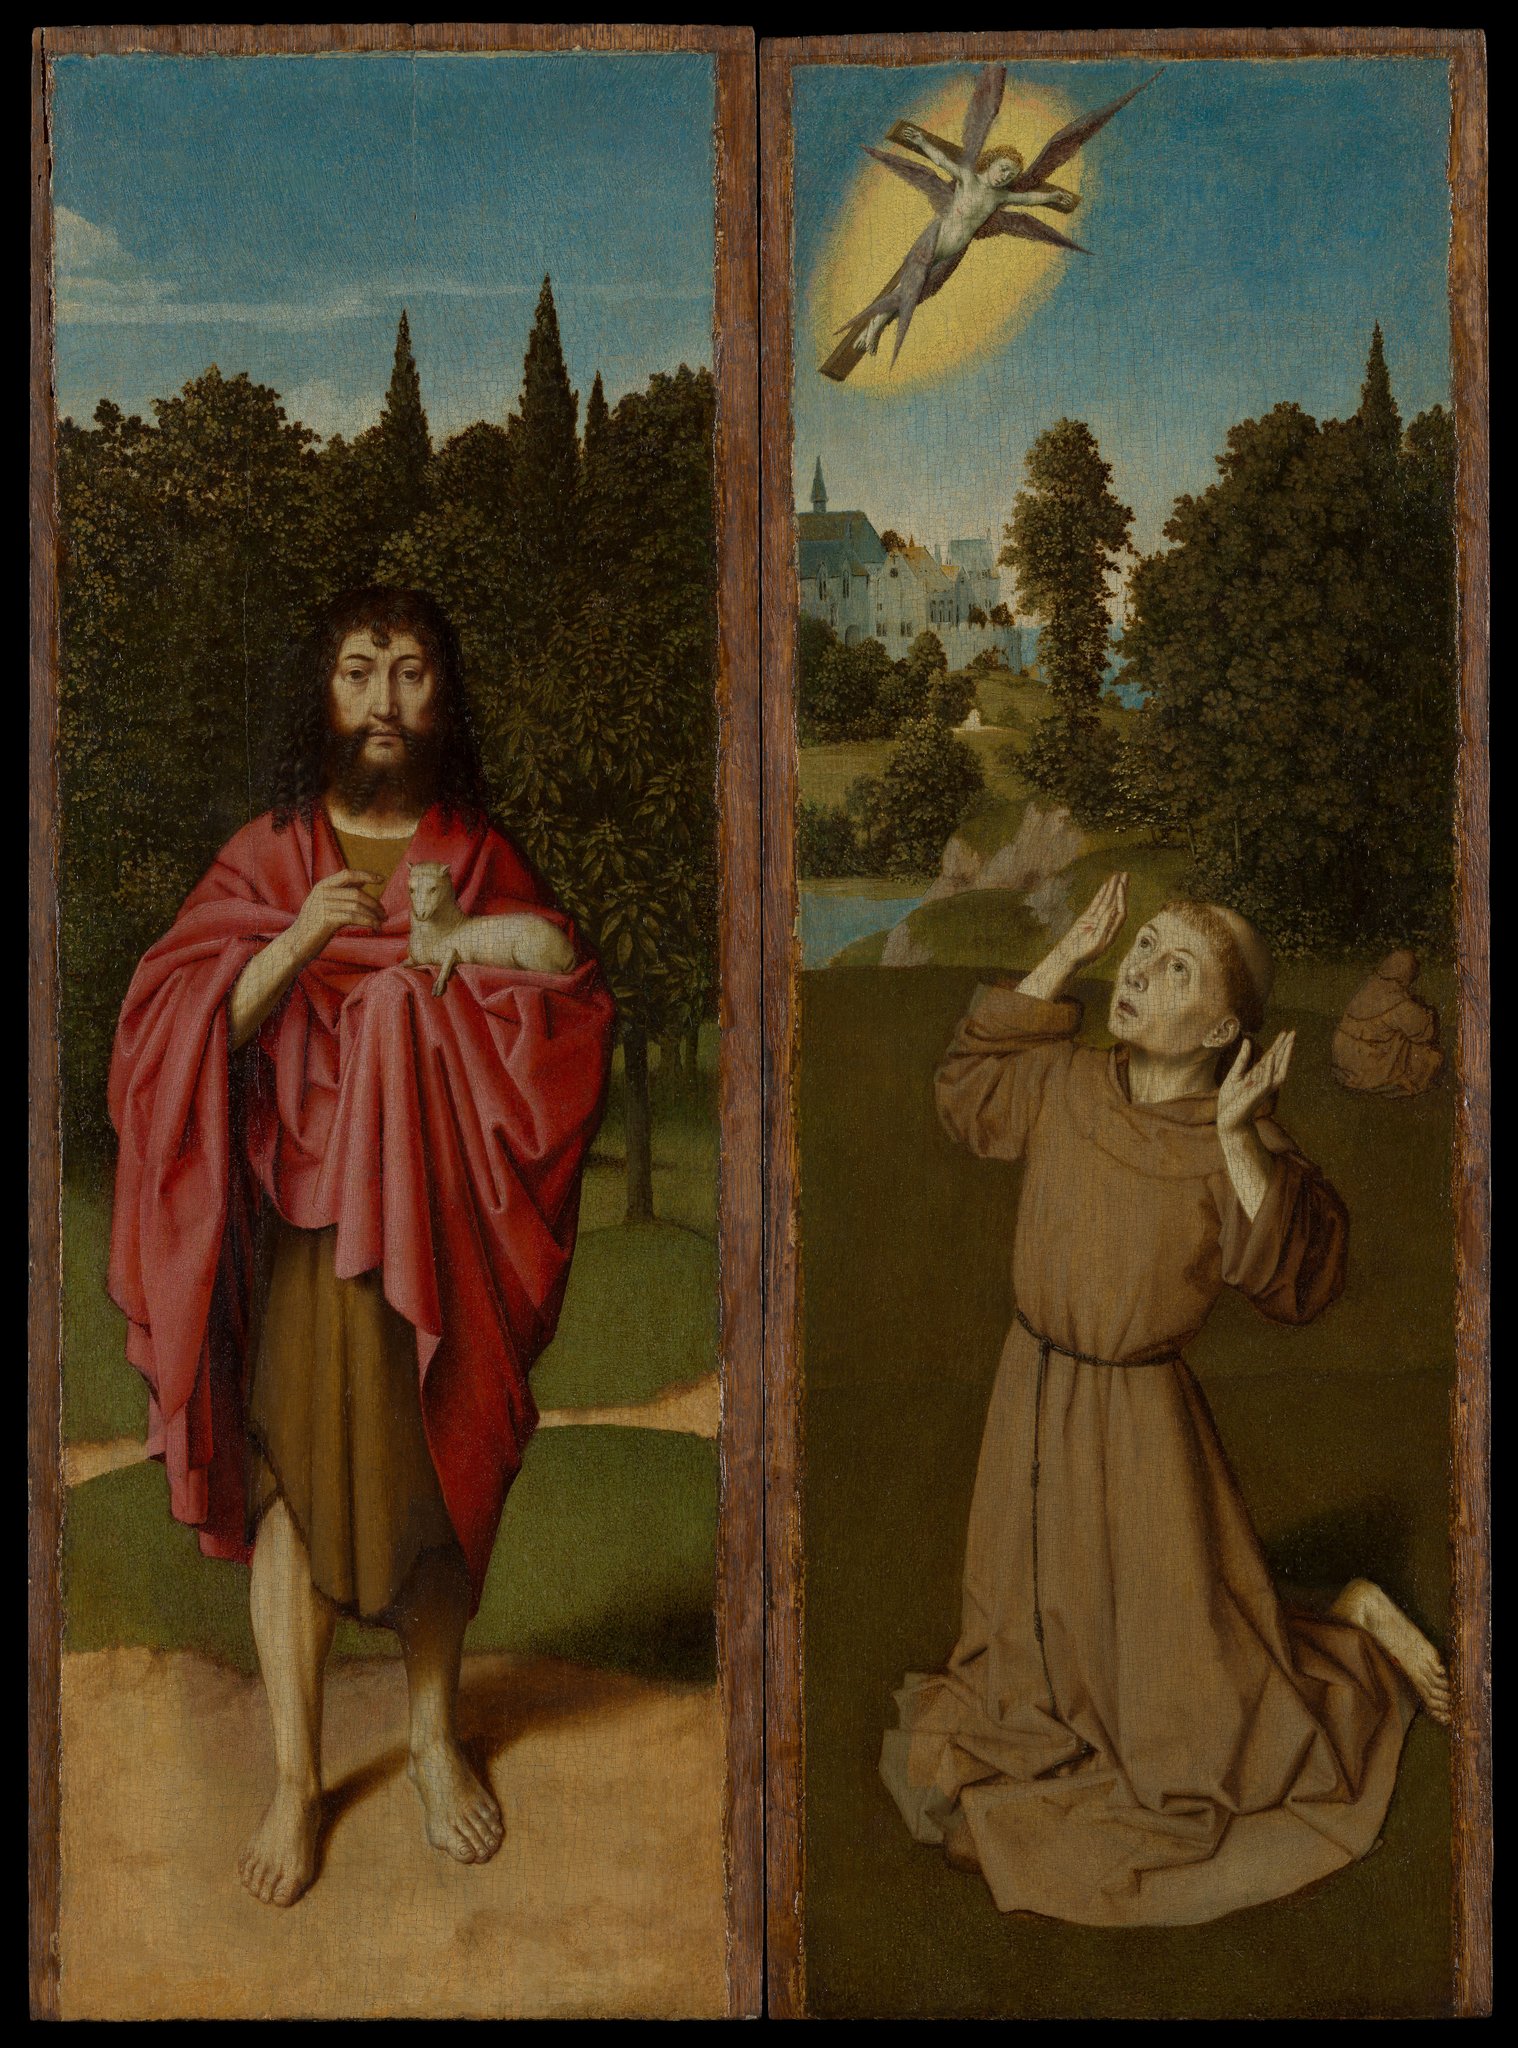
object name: painting, wing of a triptych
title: Saint John the Baptist; Saint Francis Receiving the Stigmata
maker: gerard david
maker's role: artist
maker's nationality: netherlandish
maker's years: 1455-1523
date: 1485-1490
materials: oil, wood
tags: saint francis,saint john the baptist,crucifixion